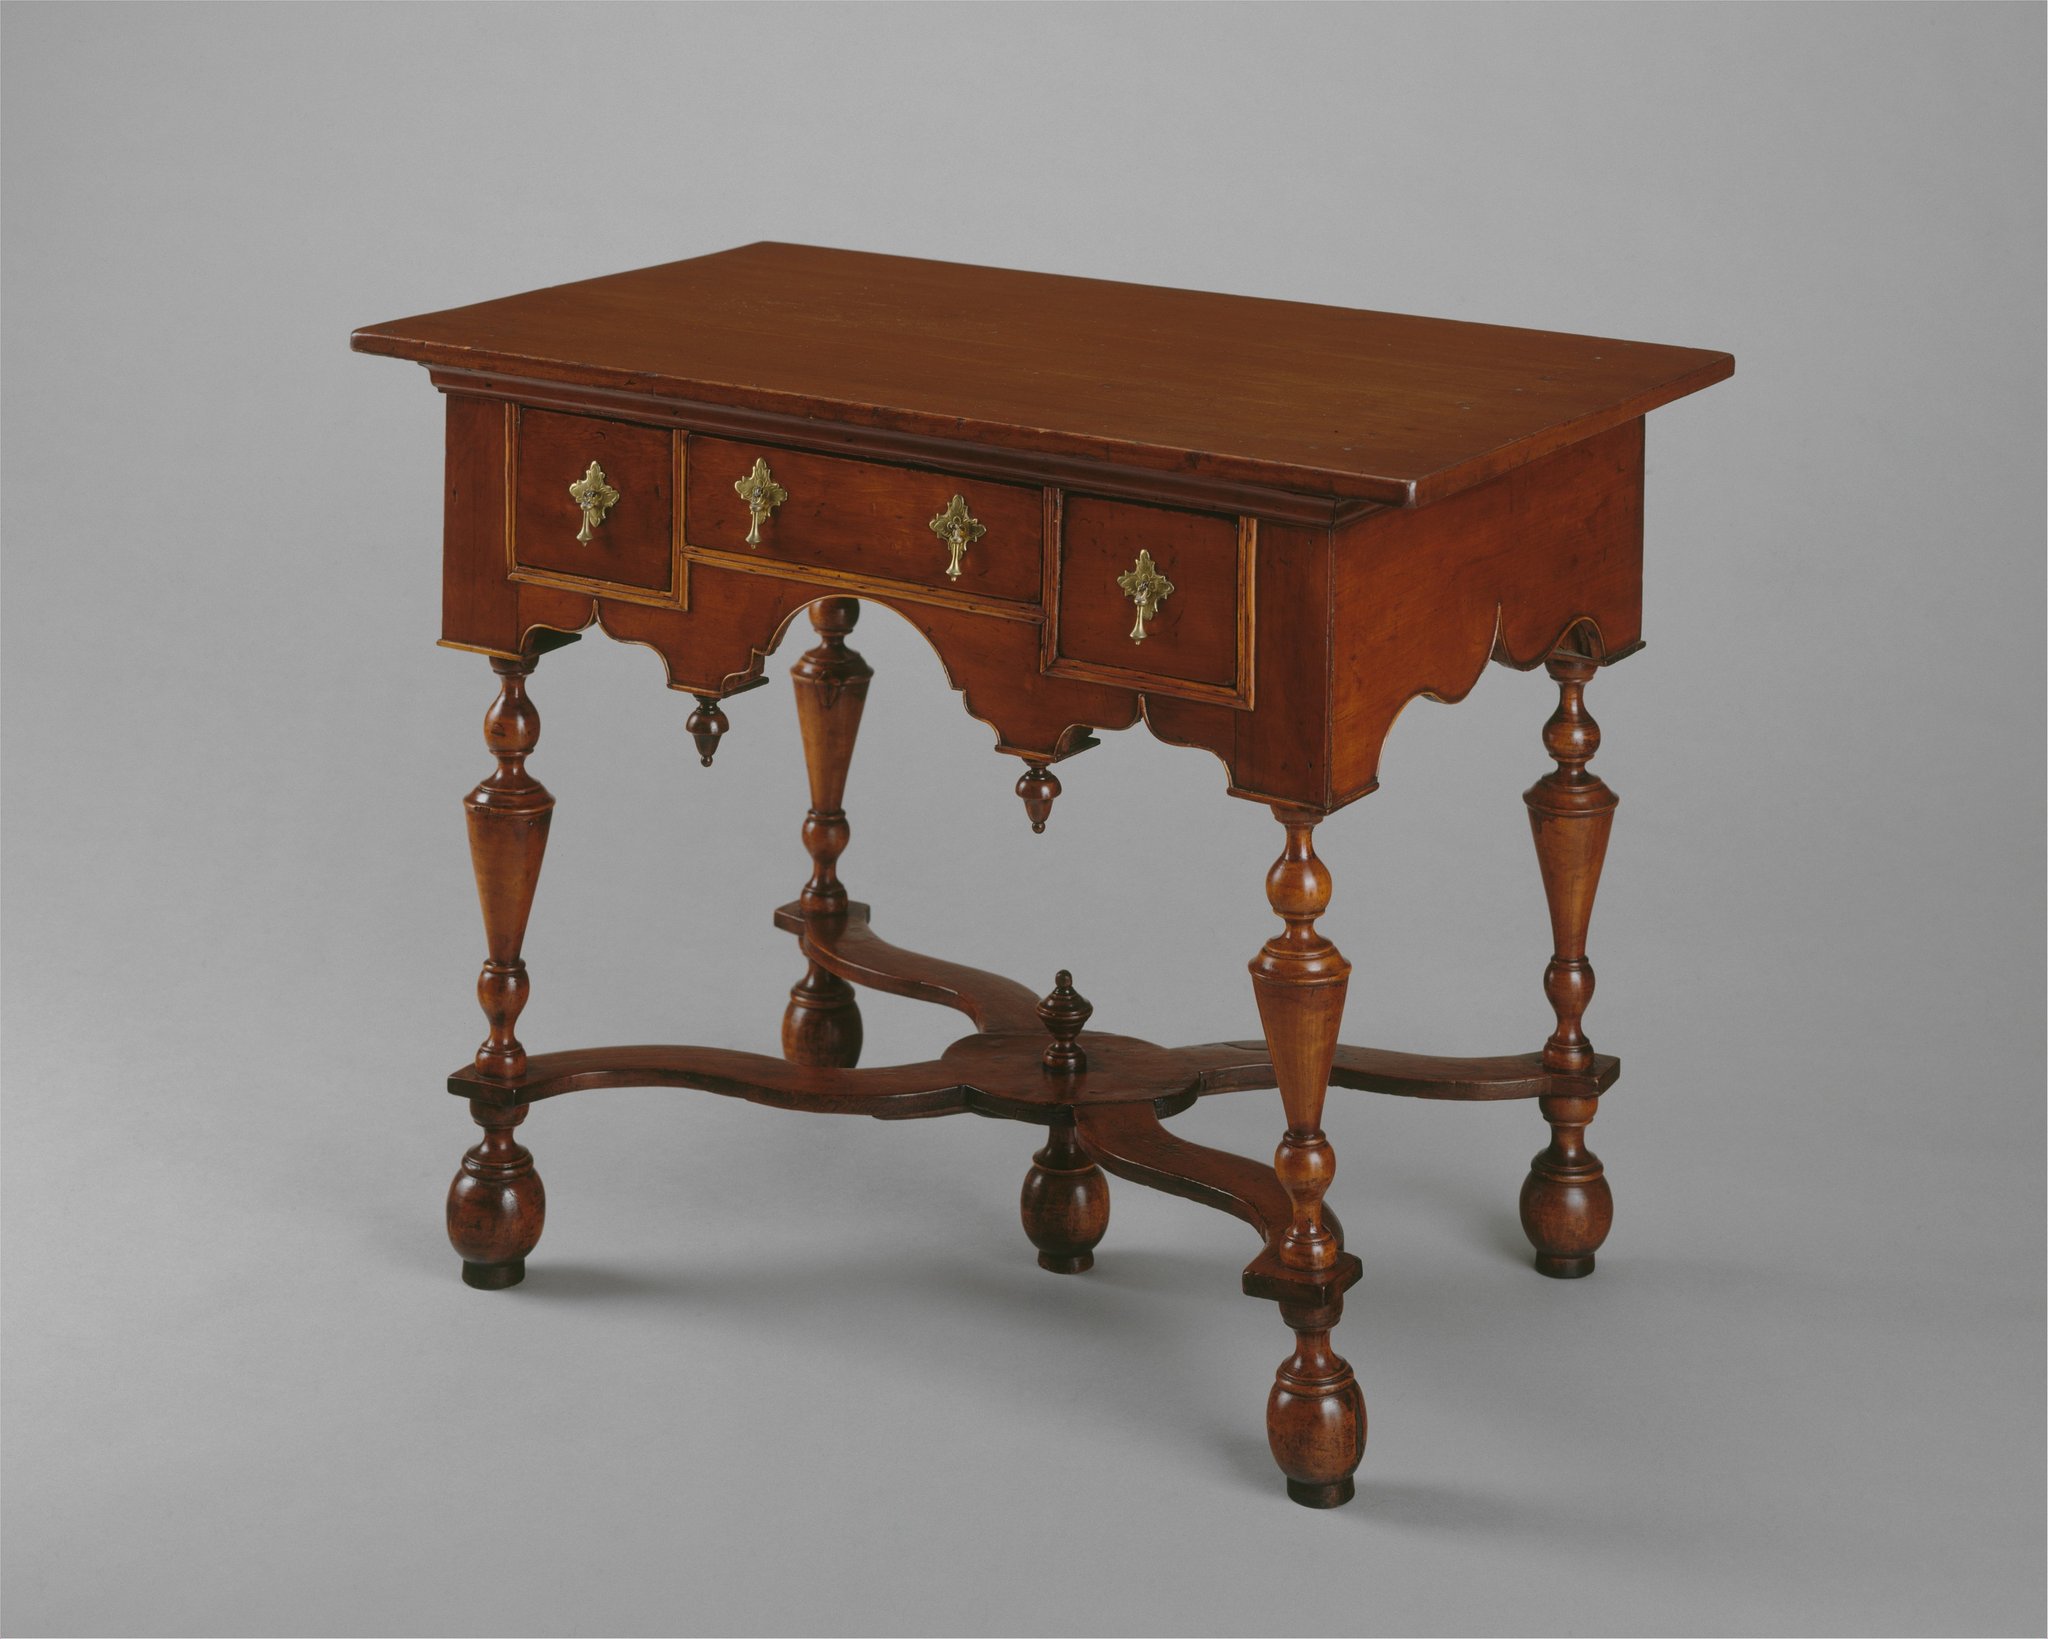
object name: dressing table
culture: american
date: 1710-1730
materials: wood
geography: united states